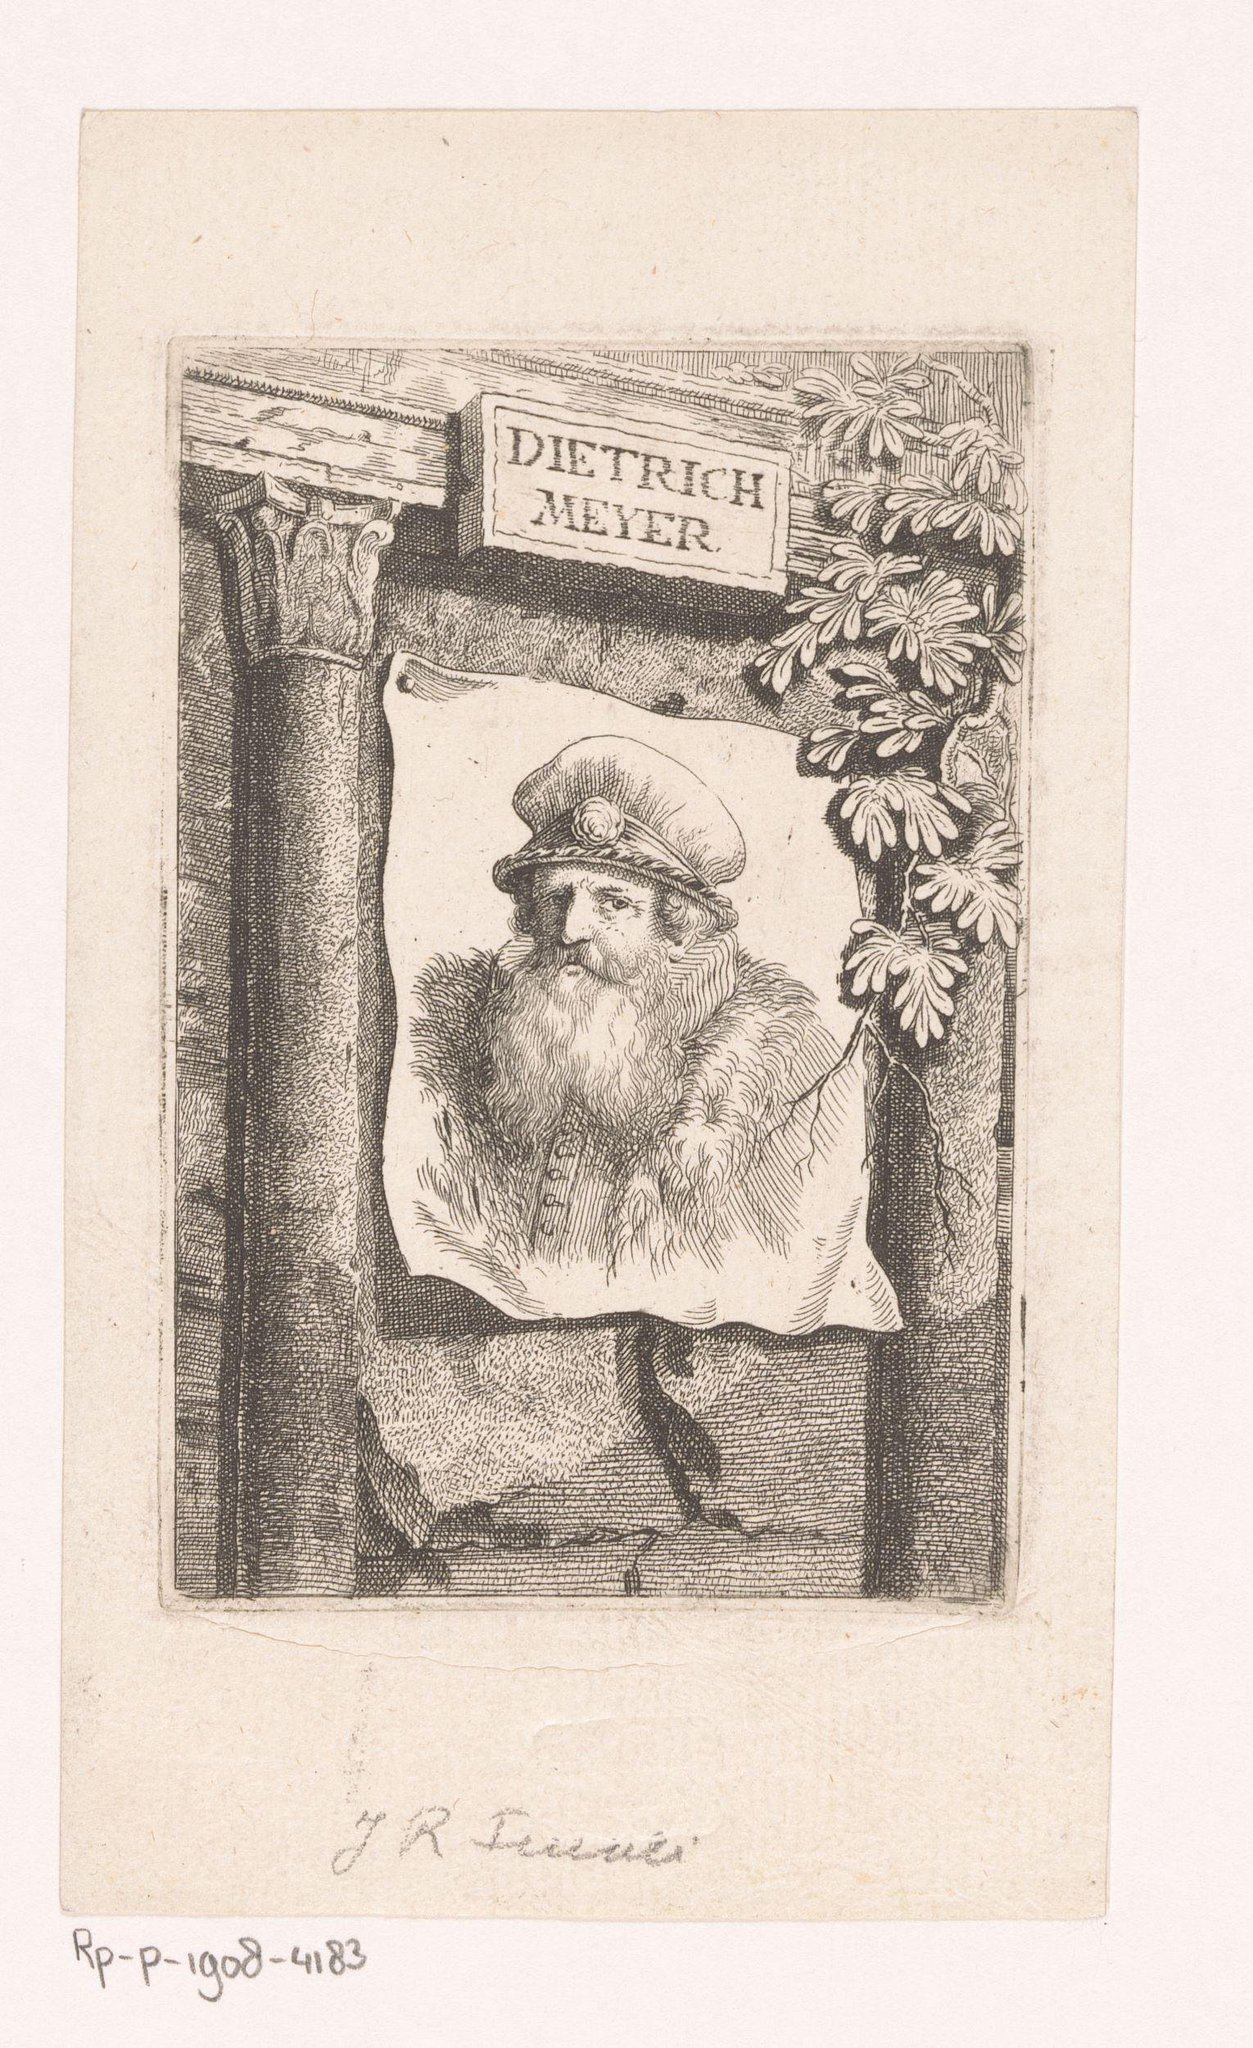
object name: print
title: Portret van Dietrich Meyer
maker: rudolf füssli (der jüngste)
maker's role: print maker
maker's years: 1737-1806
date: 1755-1757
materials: paper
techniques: etching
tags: painter, publisher, dietrich meyer, plants; vegetation, ornament derived from architectural details, portrait, self-portrait of graphic artist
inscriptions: collector's mark: Lugt 2228, collector's mark: ‘[...] in Berlin’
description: Prent gebruikt voor: Füssli, Johann Kaspar. Geschichte Und Abbildung der besten Mahler in der Schweitz. Zürich: David Gessner, 1755-1757.